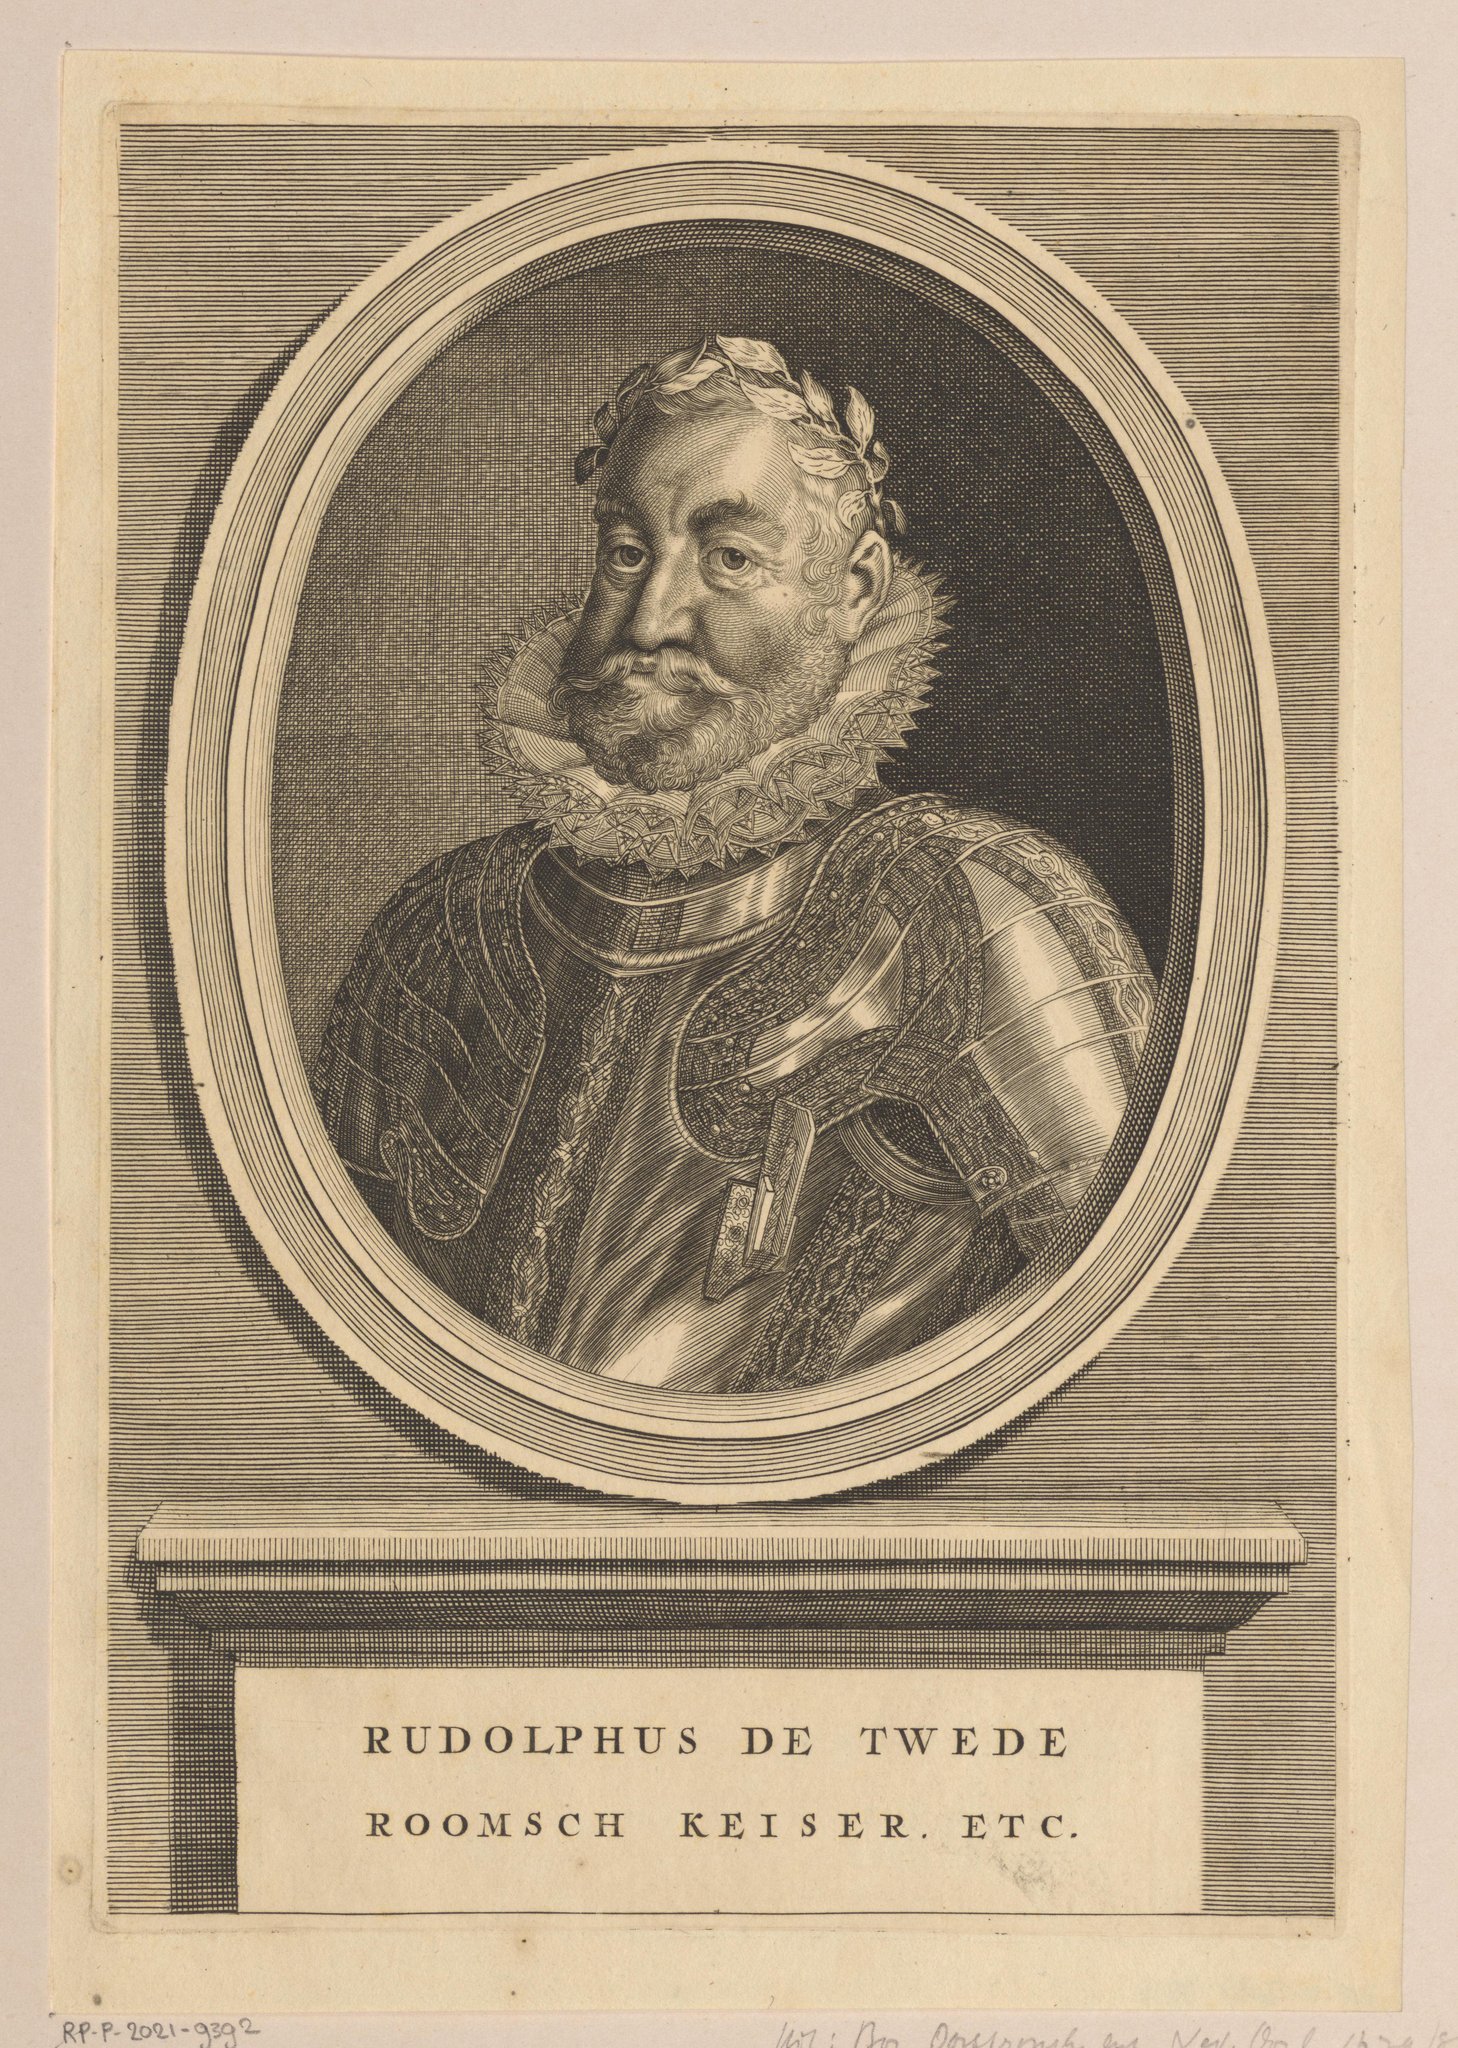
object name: print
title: Portret van Rudolf II van Habsburg, Duits keizer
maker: Anonymous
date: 1679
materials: paper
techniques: engraving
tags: rudolf ii van habsburg (duits keizer), armour, historical persons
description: Prent mogelijk uit: Bor, Pieter. Oorsprongk, begin, en vervolgh der Nederlandsche oorlogen (...) Amsterdam: weduwe Joannes van Someren, Abraham Wolfgang en Dirk Boom I, 1679, dl. 4.